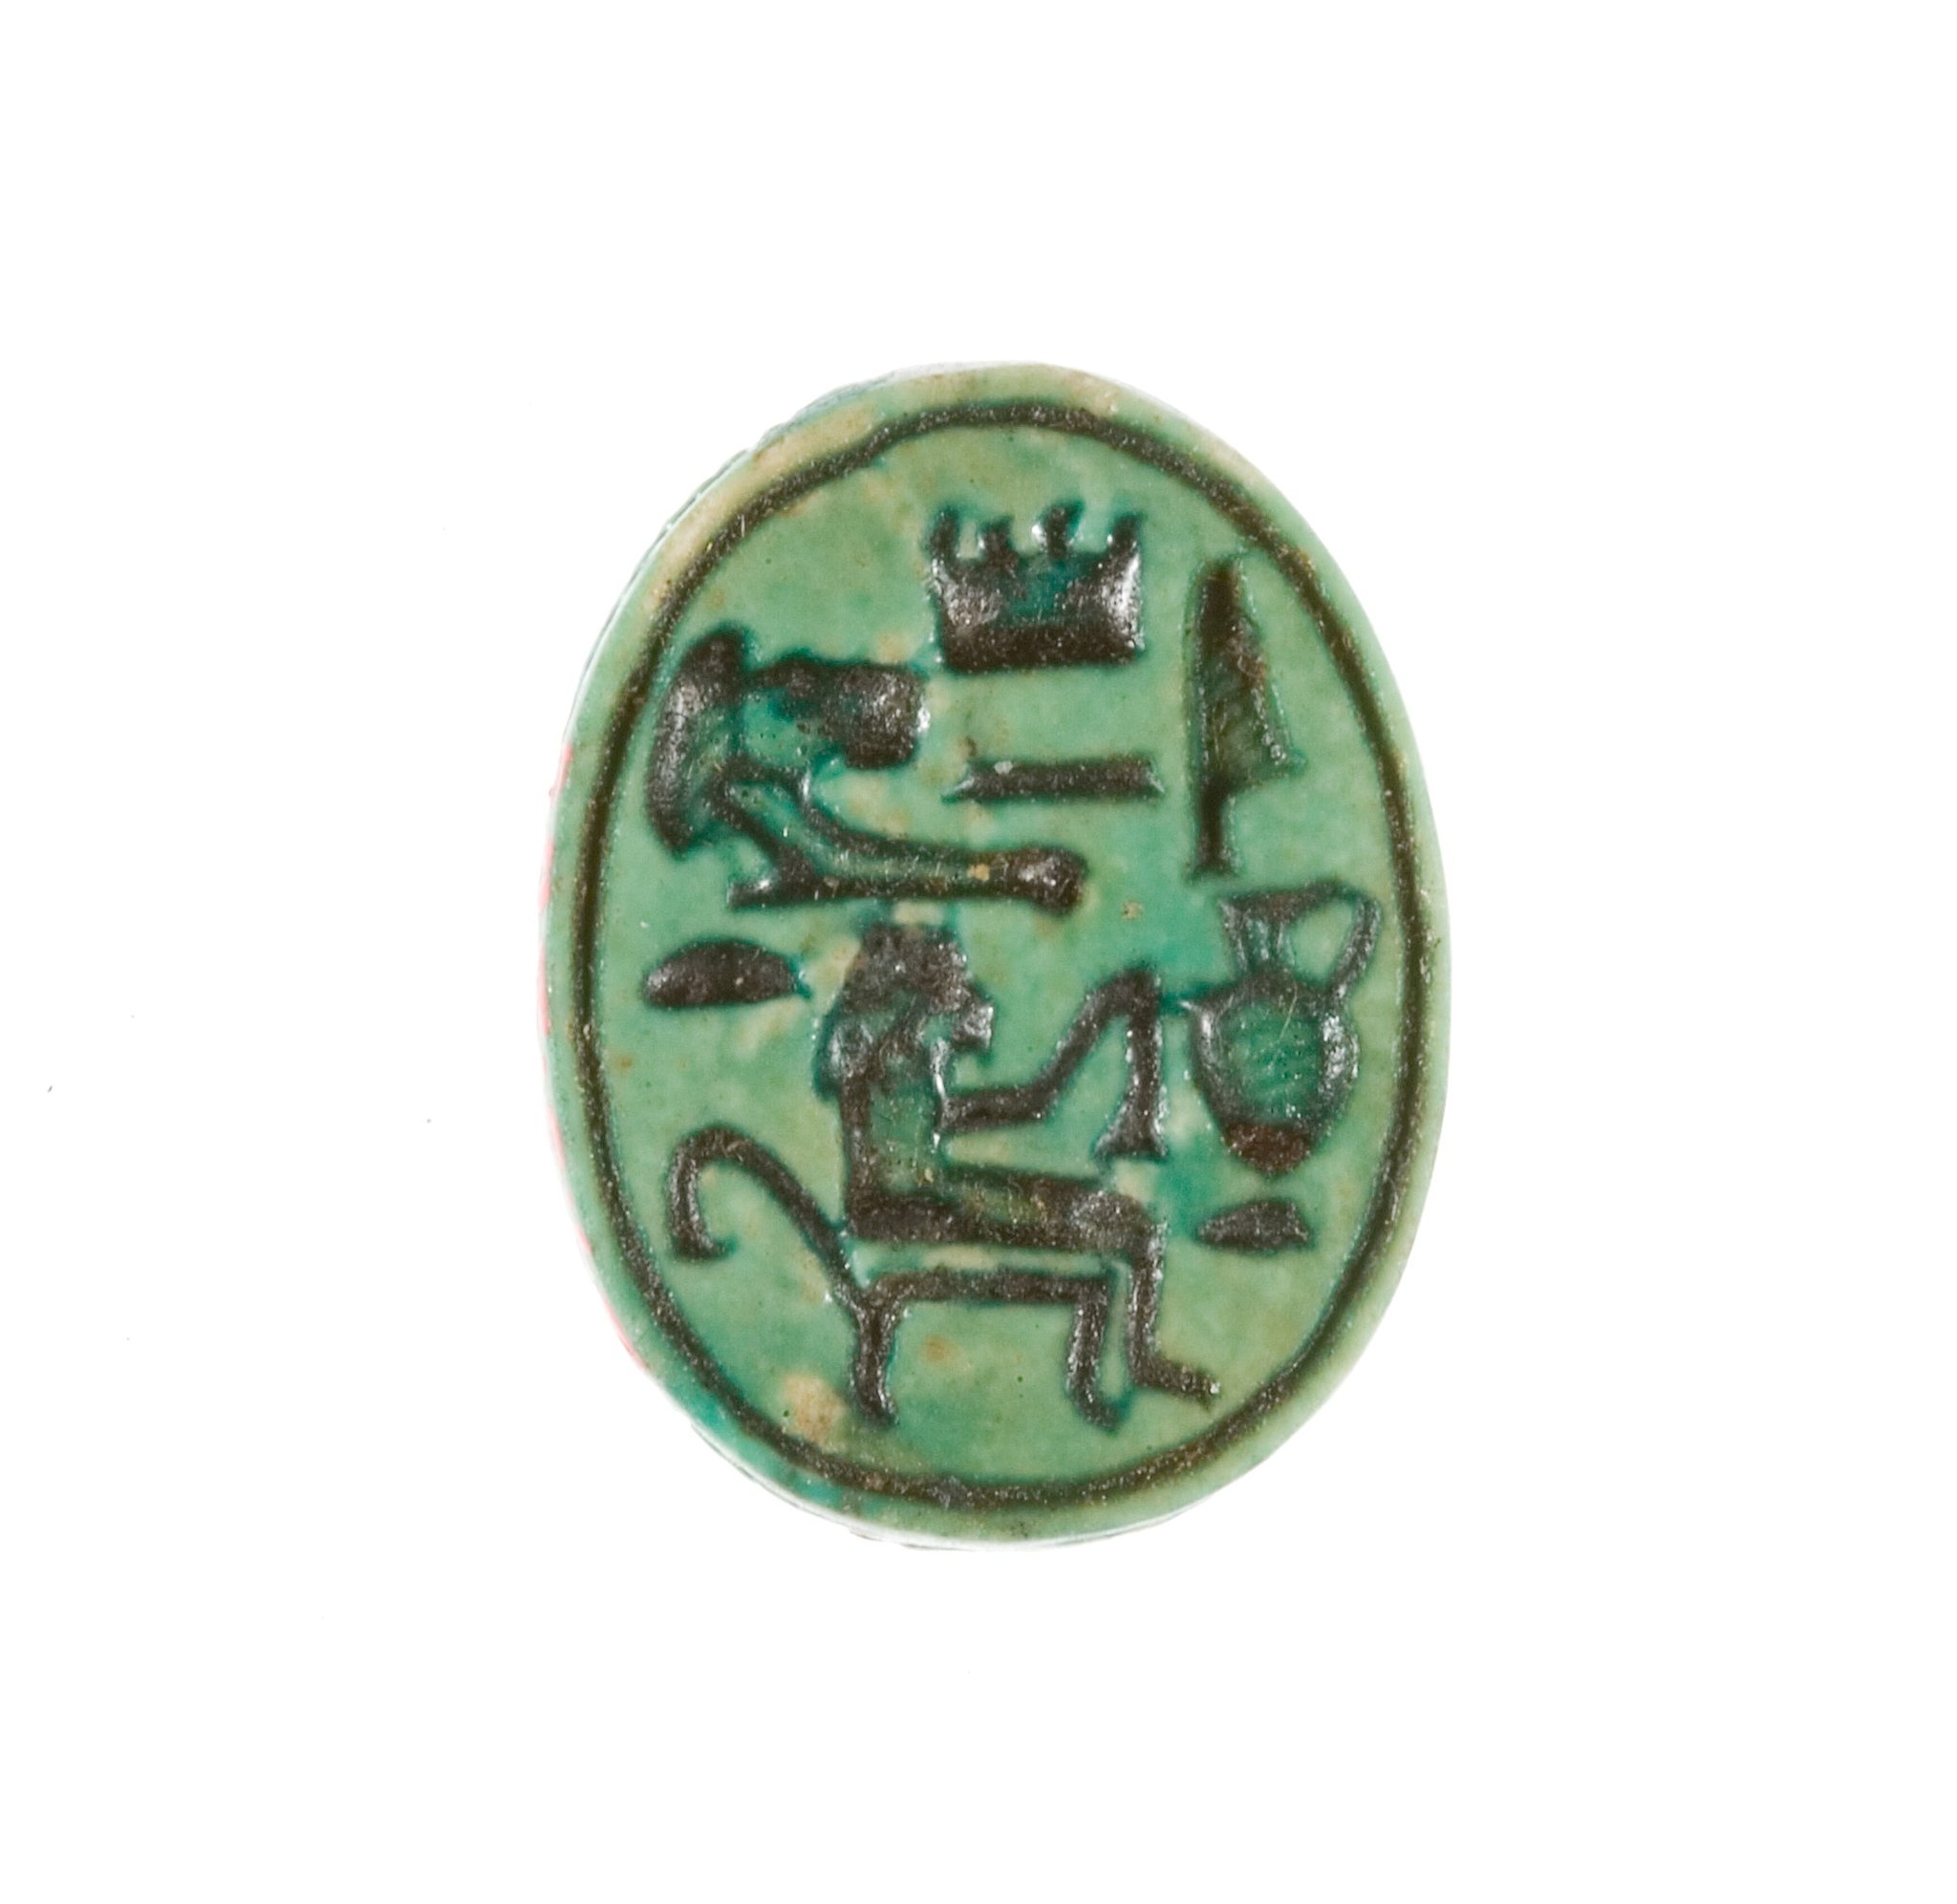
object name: scarab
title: Scarab Inscribed Hatshepsut United with Amun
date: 1479-1458 BCE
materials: stone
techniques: glazing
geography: egypt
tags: hieroglyphs,scarabs